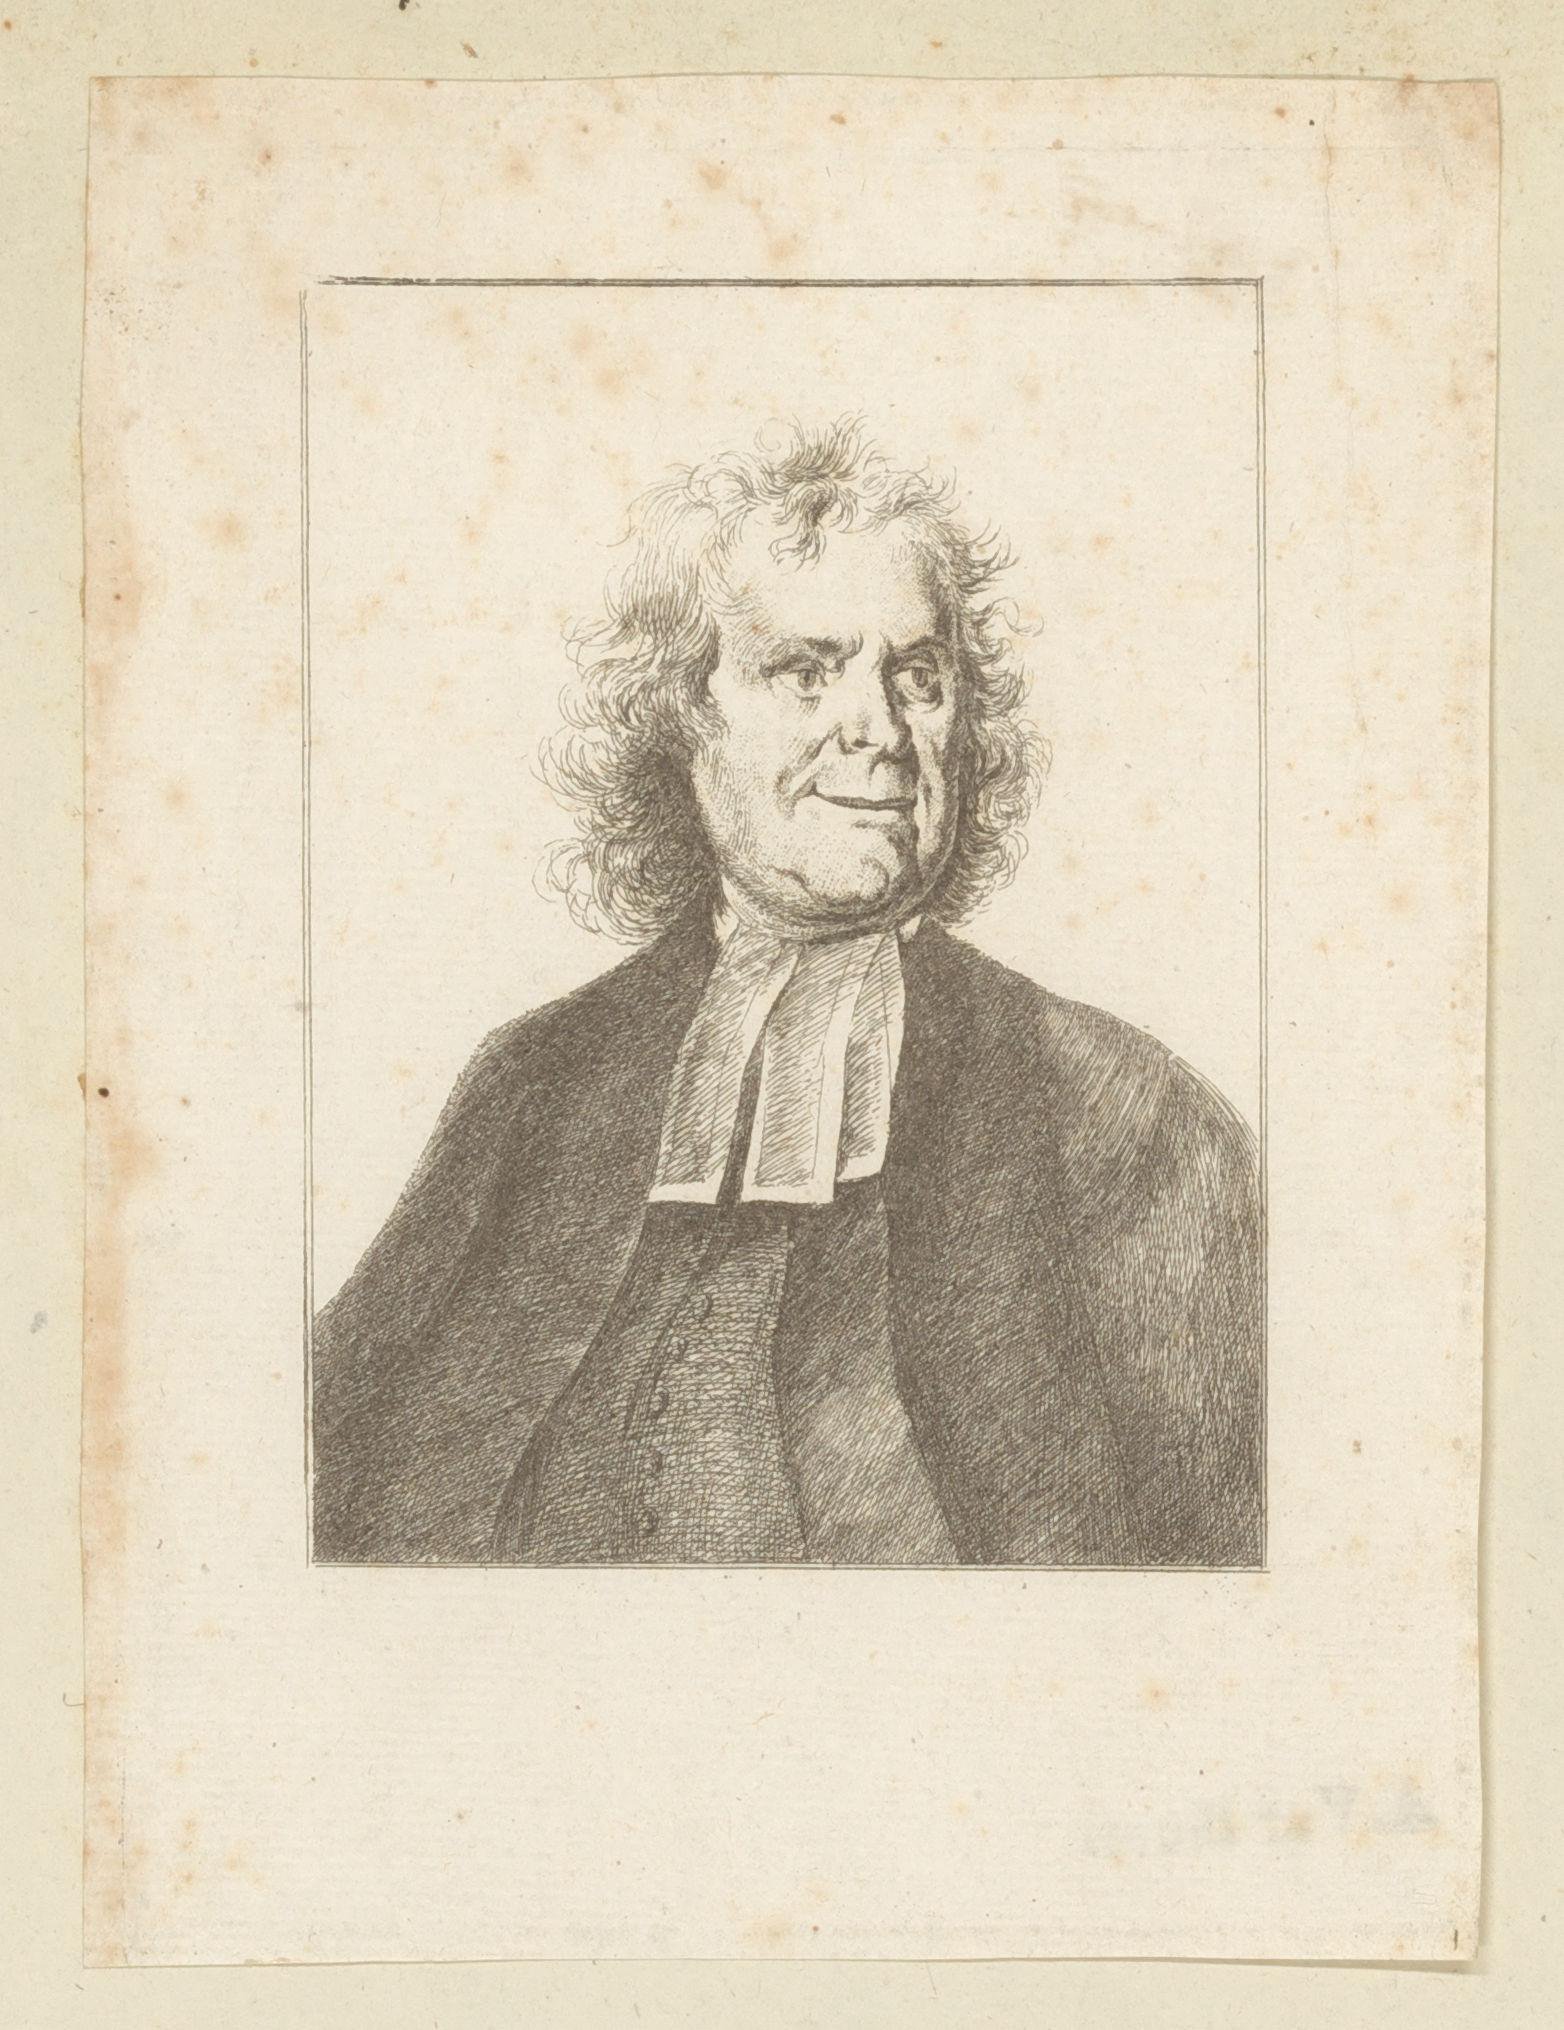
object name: print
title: Portret van Hermanus Boerhaave (versie B)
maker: jabes heenck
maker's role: draughtsman, print maker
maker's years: 1752-1782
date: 1762-1782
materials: paper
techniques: printmaking, etching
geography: the hague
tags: leiden, hermanus boerhaave, historical persons, physician, doctor (+ scholar, scientist (at work))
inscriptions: collector's mark: Lugt 2488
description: Portret van Hermanus Boerhaave, buste, driekwart naar rechts. Tegendruk van de versie B van het portret, door Heenck. Samen met drie andere versies van deze prent opgezet op een blad met een handschrift met de anekdote over het aan stukken snijden van de koperplaat door de dochter van Boerhaave.